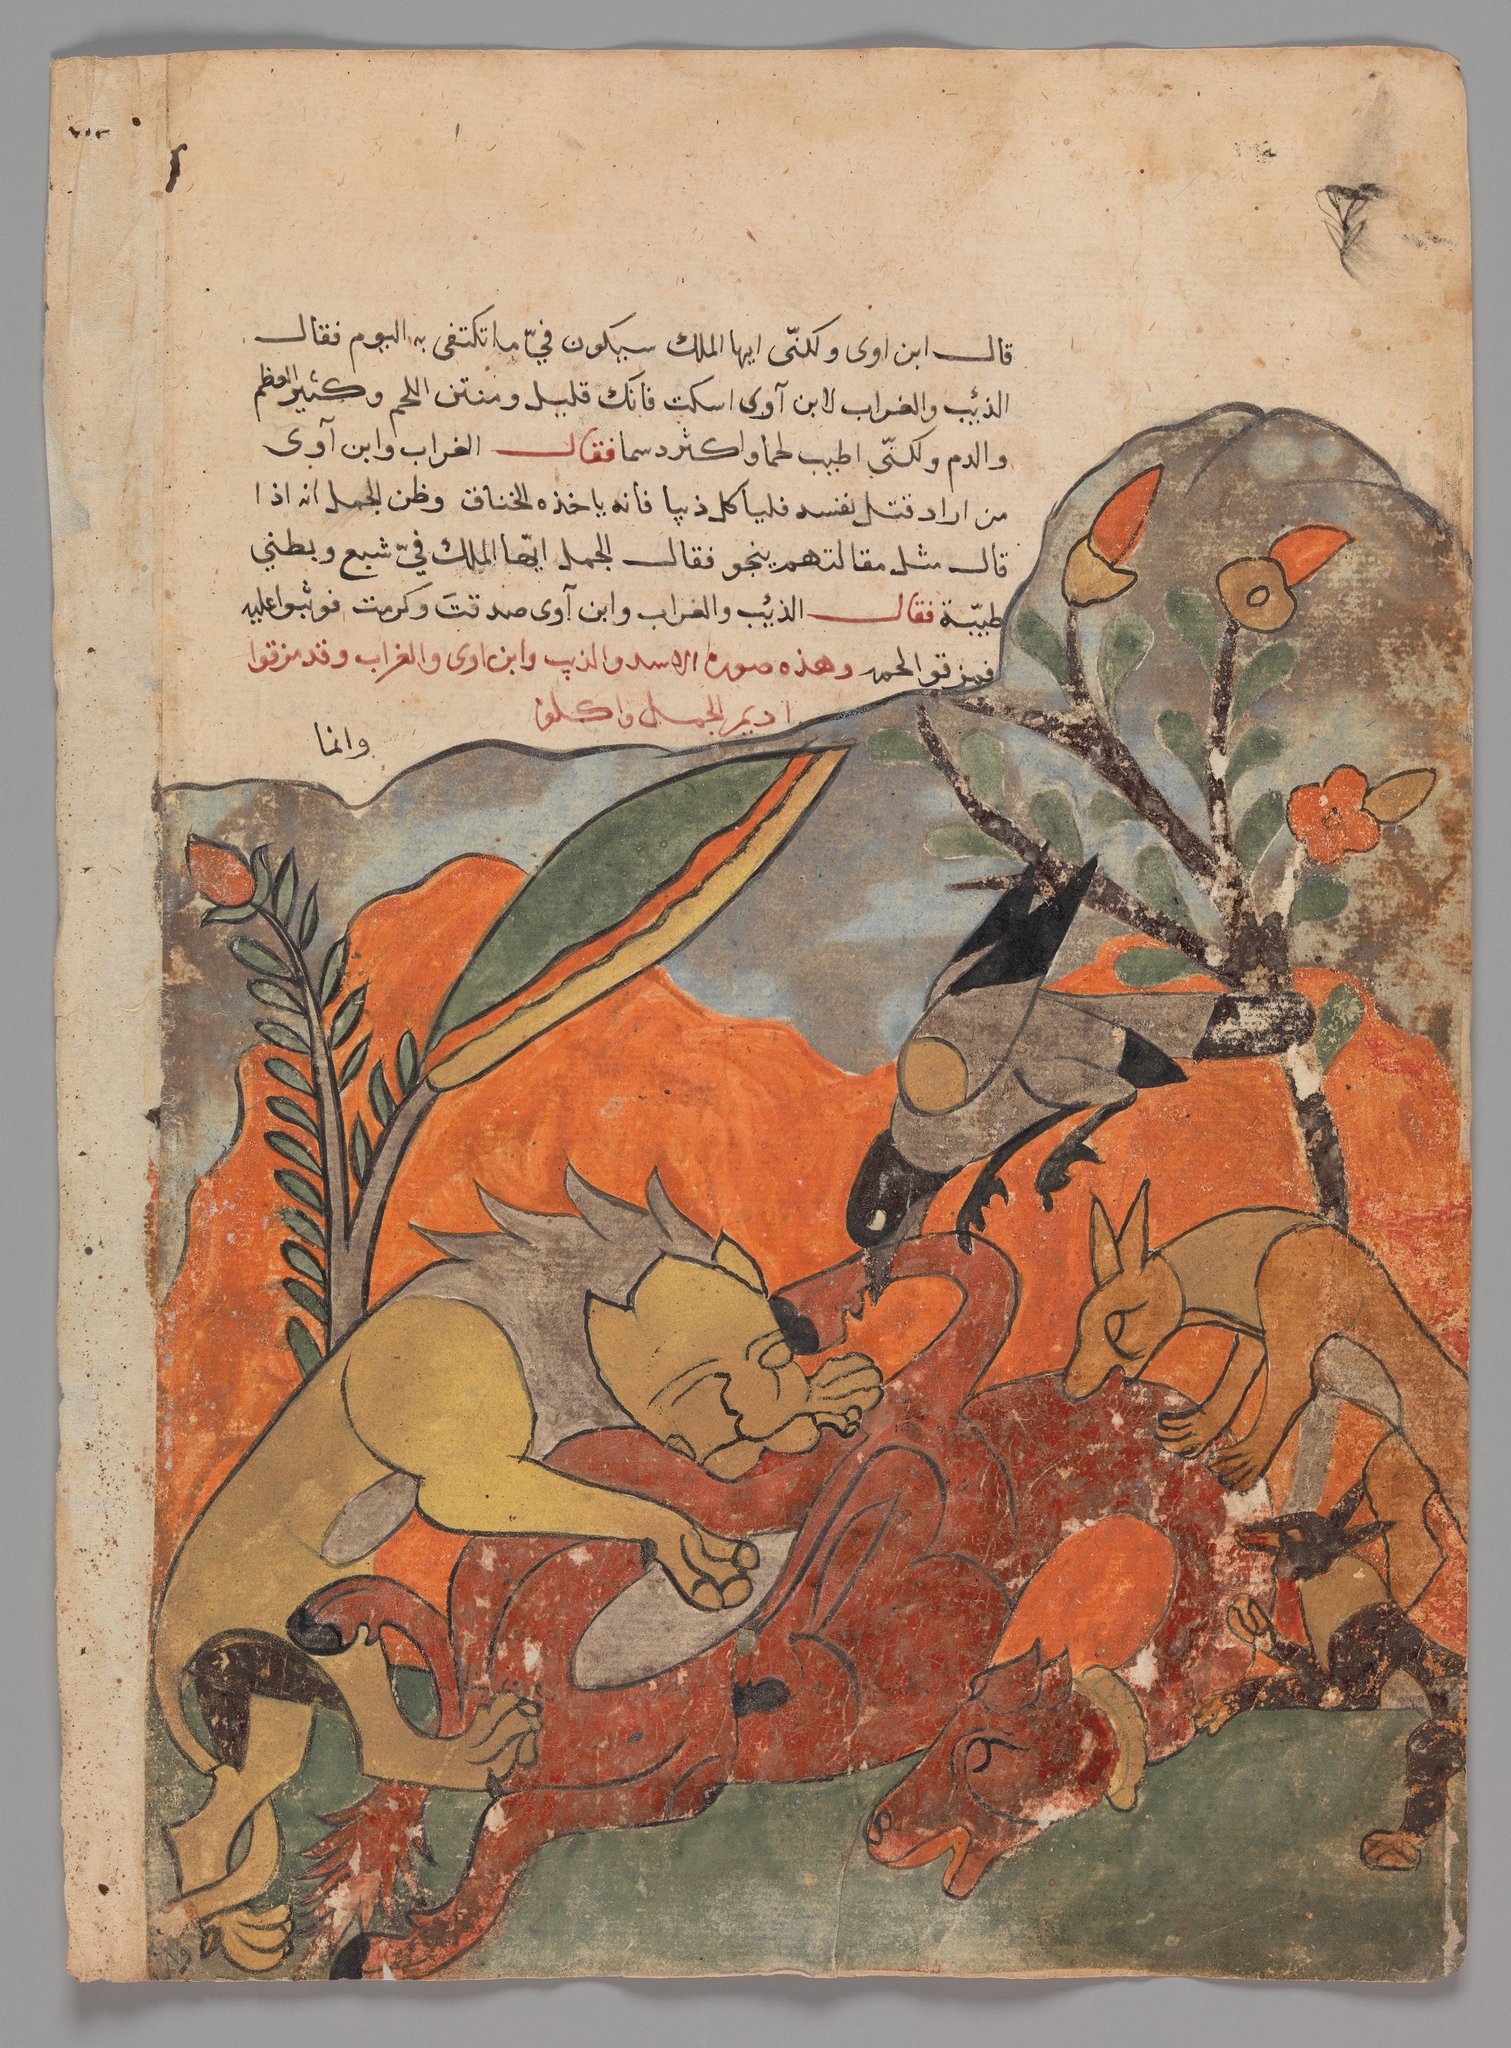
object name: folio from an illustrated manuscript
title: "The Attack on the Camel by the Lion, Crow, Wolf, and Jackal", Folio from a Kalila wa Dimna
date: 1526-1550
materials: ink, paper, watercolor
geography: india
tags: camels,lions